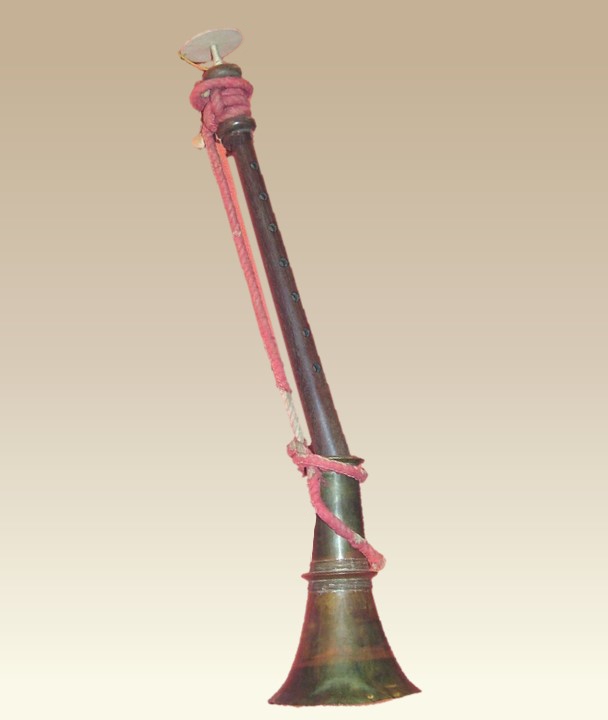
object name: hnè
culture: burmese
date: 1867-1900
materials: wood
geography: myanmar